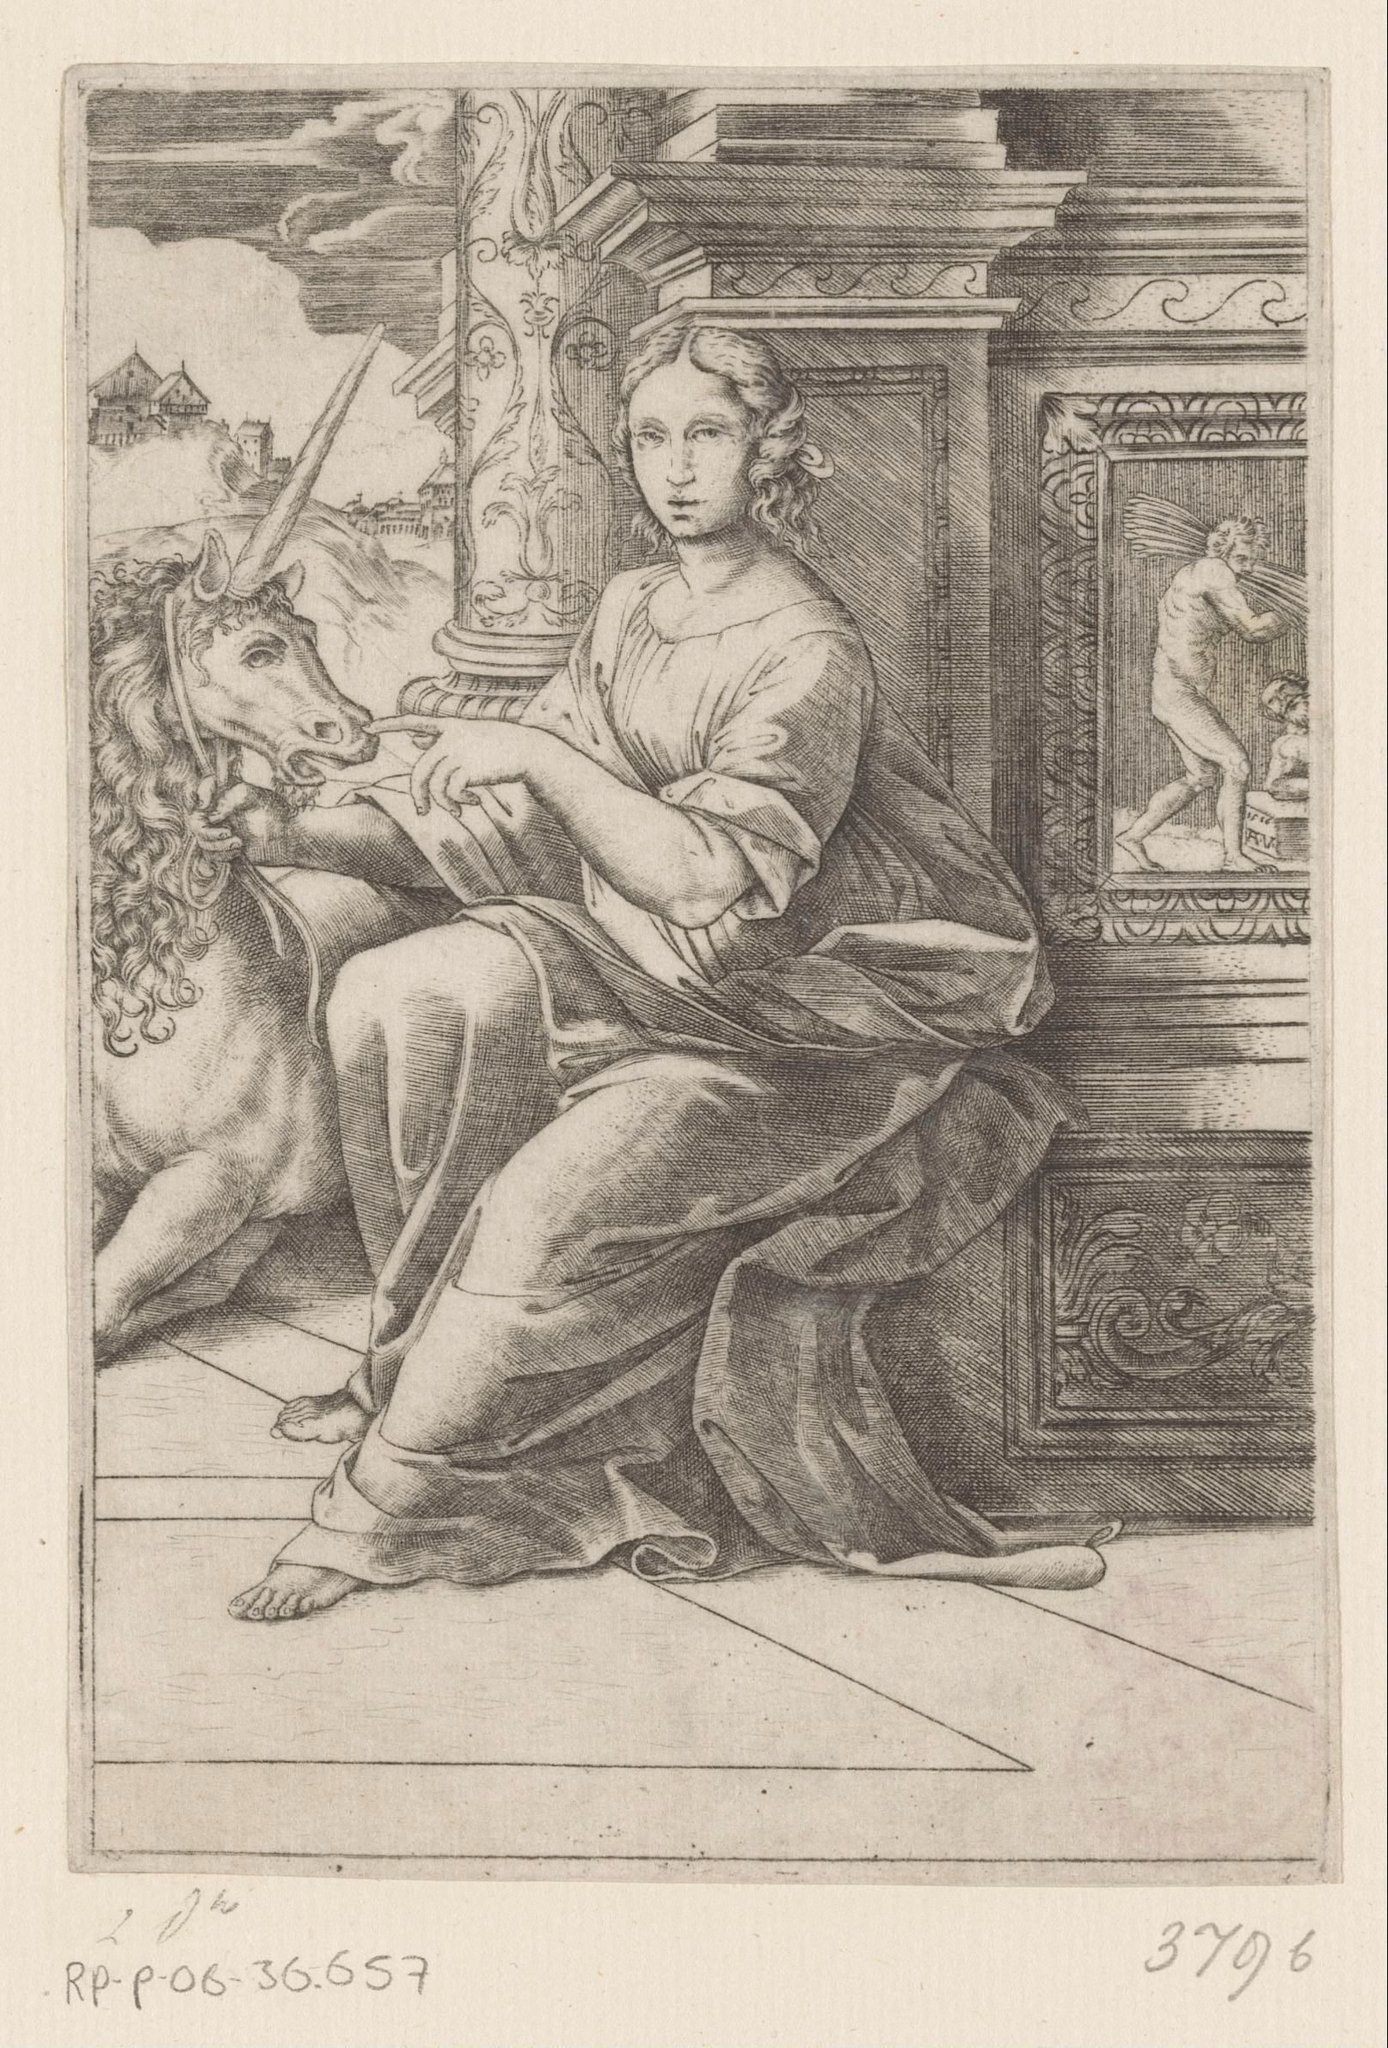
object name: print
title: Kuisheid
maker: agostino veneziano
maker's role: draughtsman, painter, print maker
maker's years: 1490-1536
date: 1516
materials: paper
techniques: engraving, etching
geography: italy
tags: unicorn, 'castità ', 'pudicitia', 'vergogna honesta' (ripa)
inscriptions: collector's mark: Lugt 12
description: Volgens Bartsch is deze prent naar ontwerp van Rafaël. Er zijn echter ook overeenkomsten met een tekening door Leonardo da Vinci in het British Museum te Londen (inv.nr. 1860,0616.98).